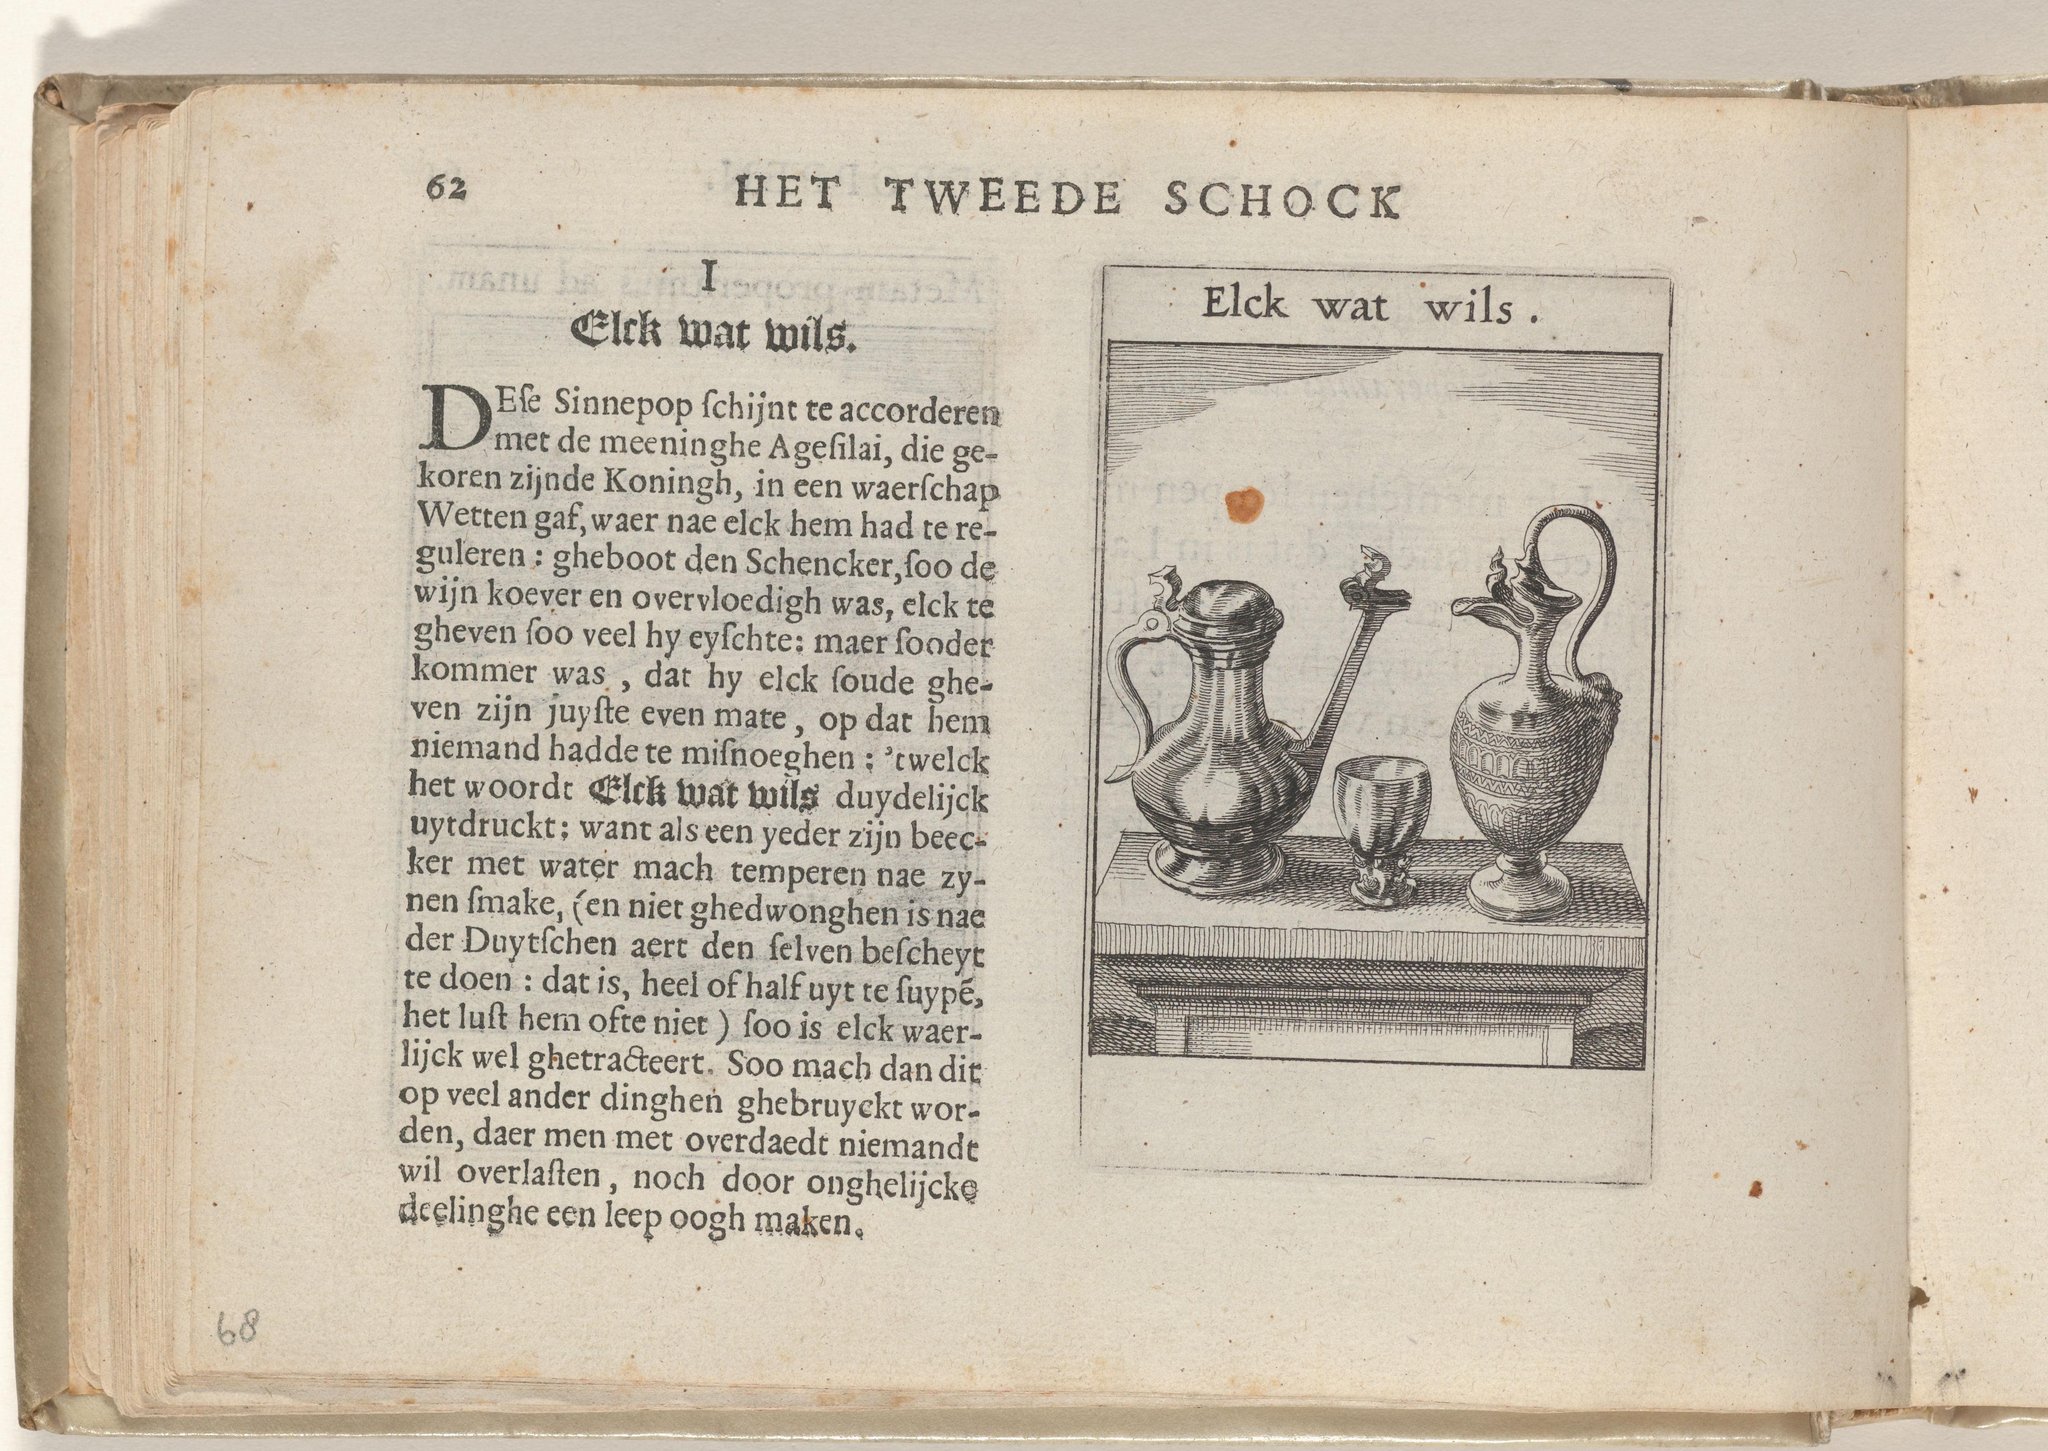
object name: print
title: I Elck wat wils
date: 1614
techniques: engraving, printing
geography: amsterdam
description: I Elck wat wils. Tweede schok. Onderdeel van 'Sinnepoppen', R. Visscher, 1614.